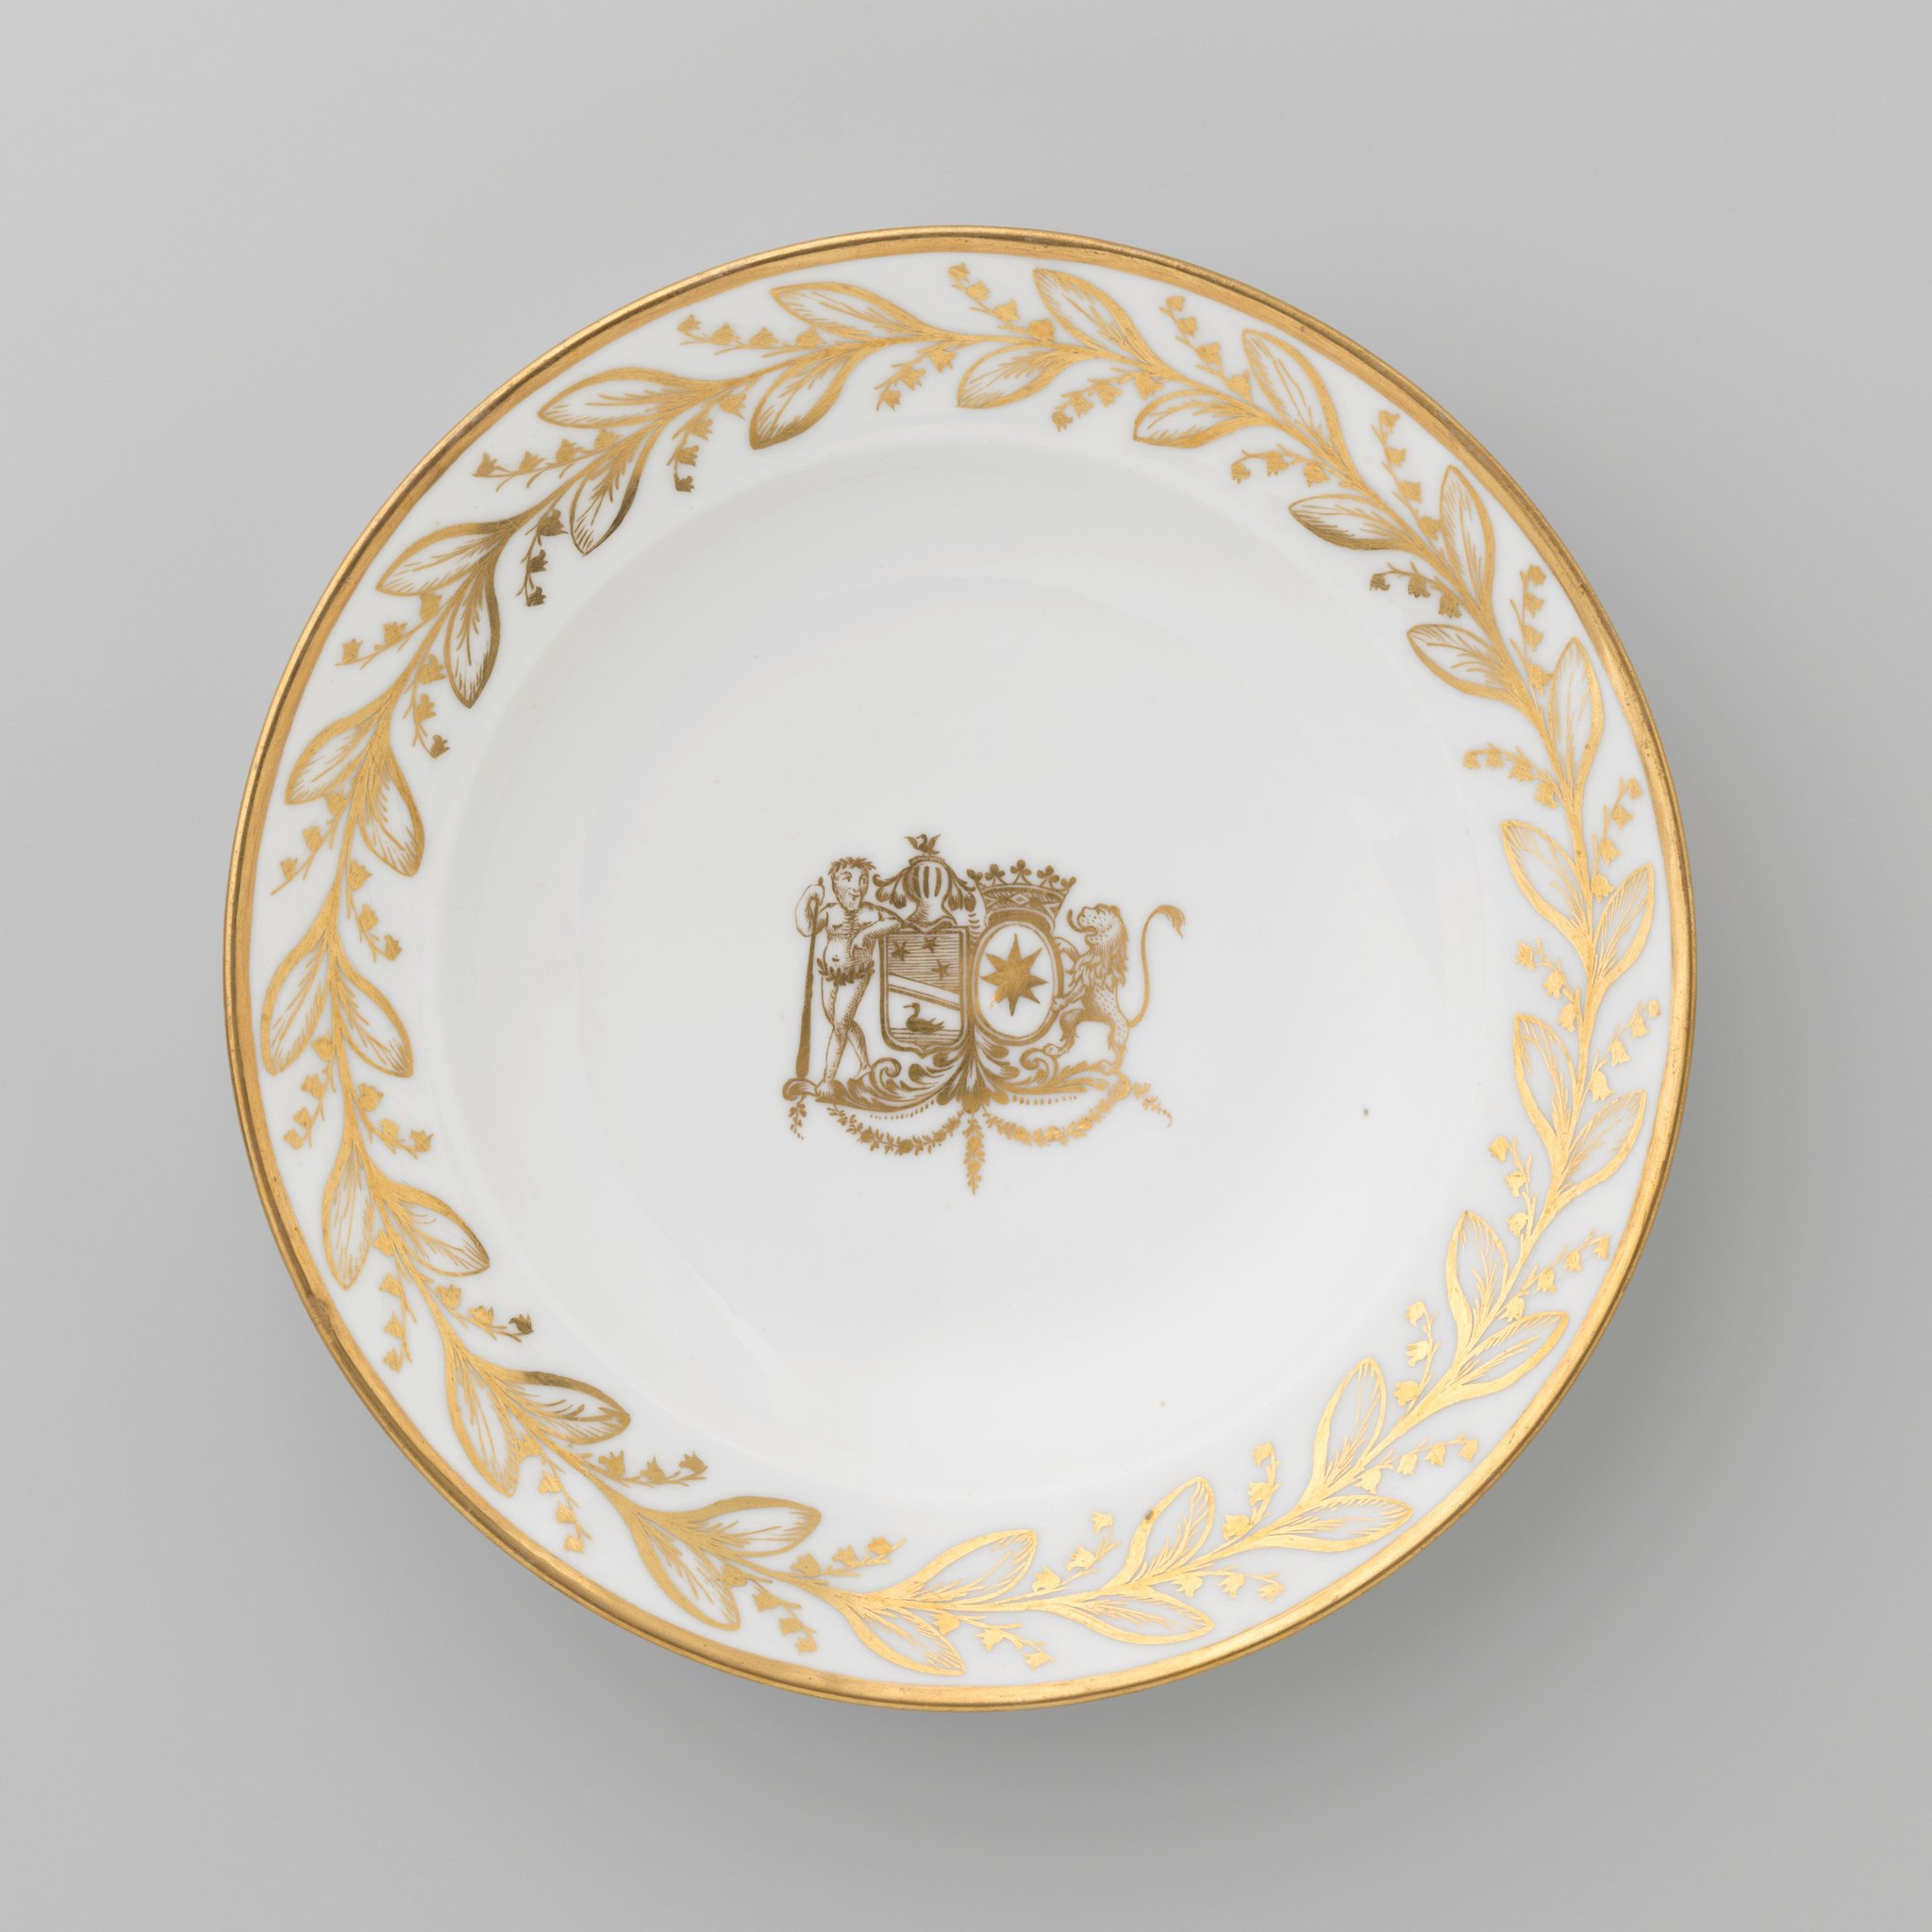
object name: plate dish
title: Plate with the coat of arms of Hendrik Peter Godfried Quack and Isabella Gertraud von Carnap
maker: Anonymous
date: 1790-1800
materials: glaze, gold, paint, porcelain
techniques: firing, forming, gilding, turning, vitrification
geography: netherlands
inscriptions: mark: ‘N’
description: Diep bord van porselein, beschilderd op het glazuur met goud. Op het plat het alliantiewapen van Hendrik Peter Godfried Quack en Isabella Gertraud von Carnap. De rand met een bloemrank en een gouden band. Twee proenen op de onderzijde. Gemerkt op de onderzijde met N.